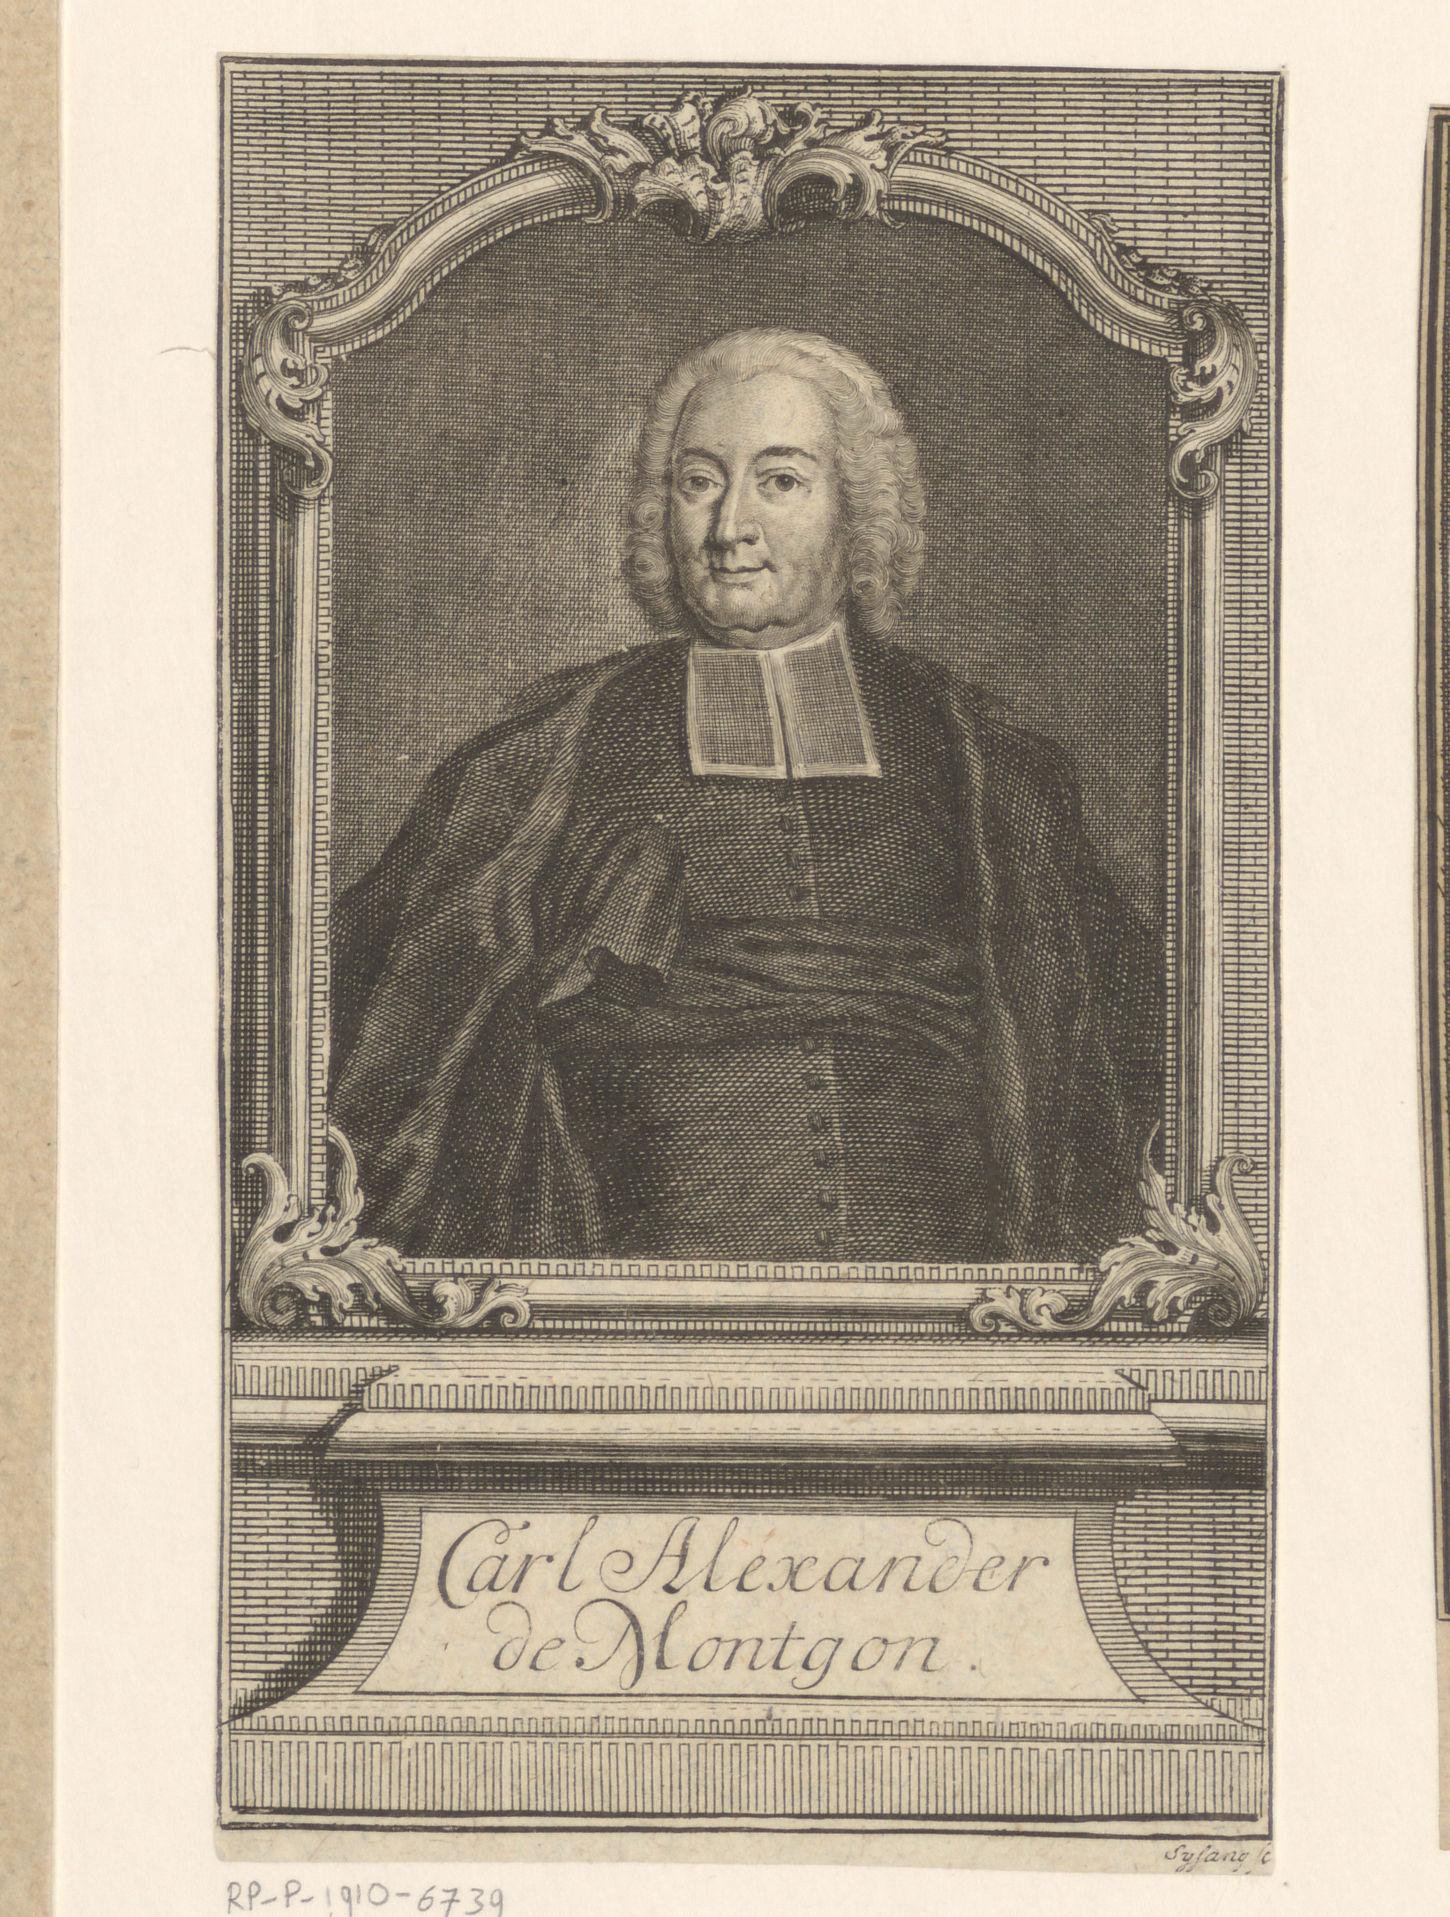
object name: print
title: Portret van Charles-Alexandre de Montgon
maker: johann christoph sysang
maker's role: print maker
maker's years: 1703-1757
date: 1720-1757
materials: paper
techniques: engraving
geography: germany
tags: belgium, historical persons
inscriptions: collector's mark: Lugt 2228